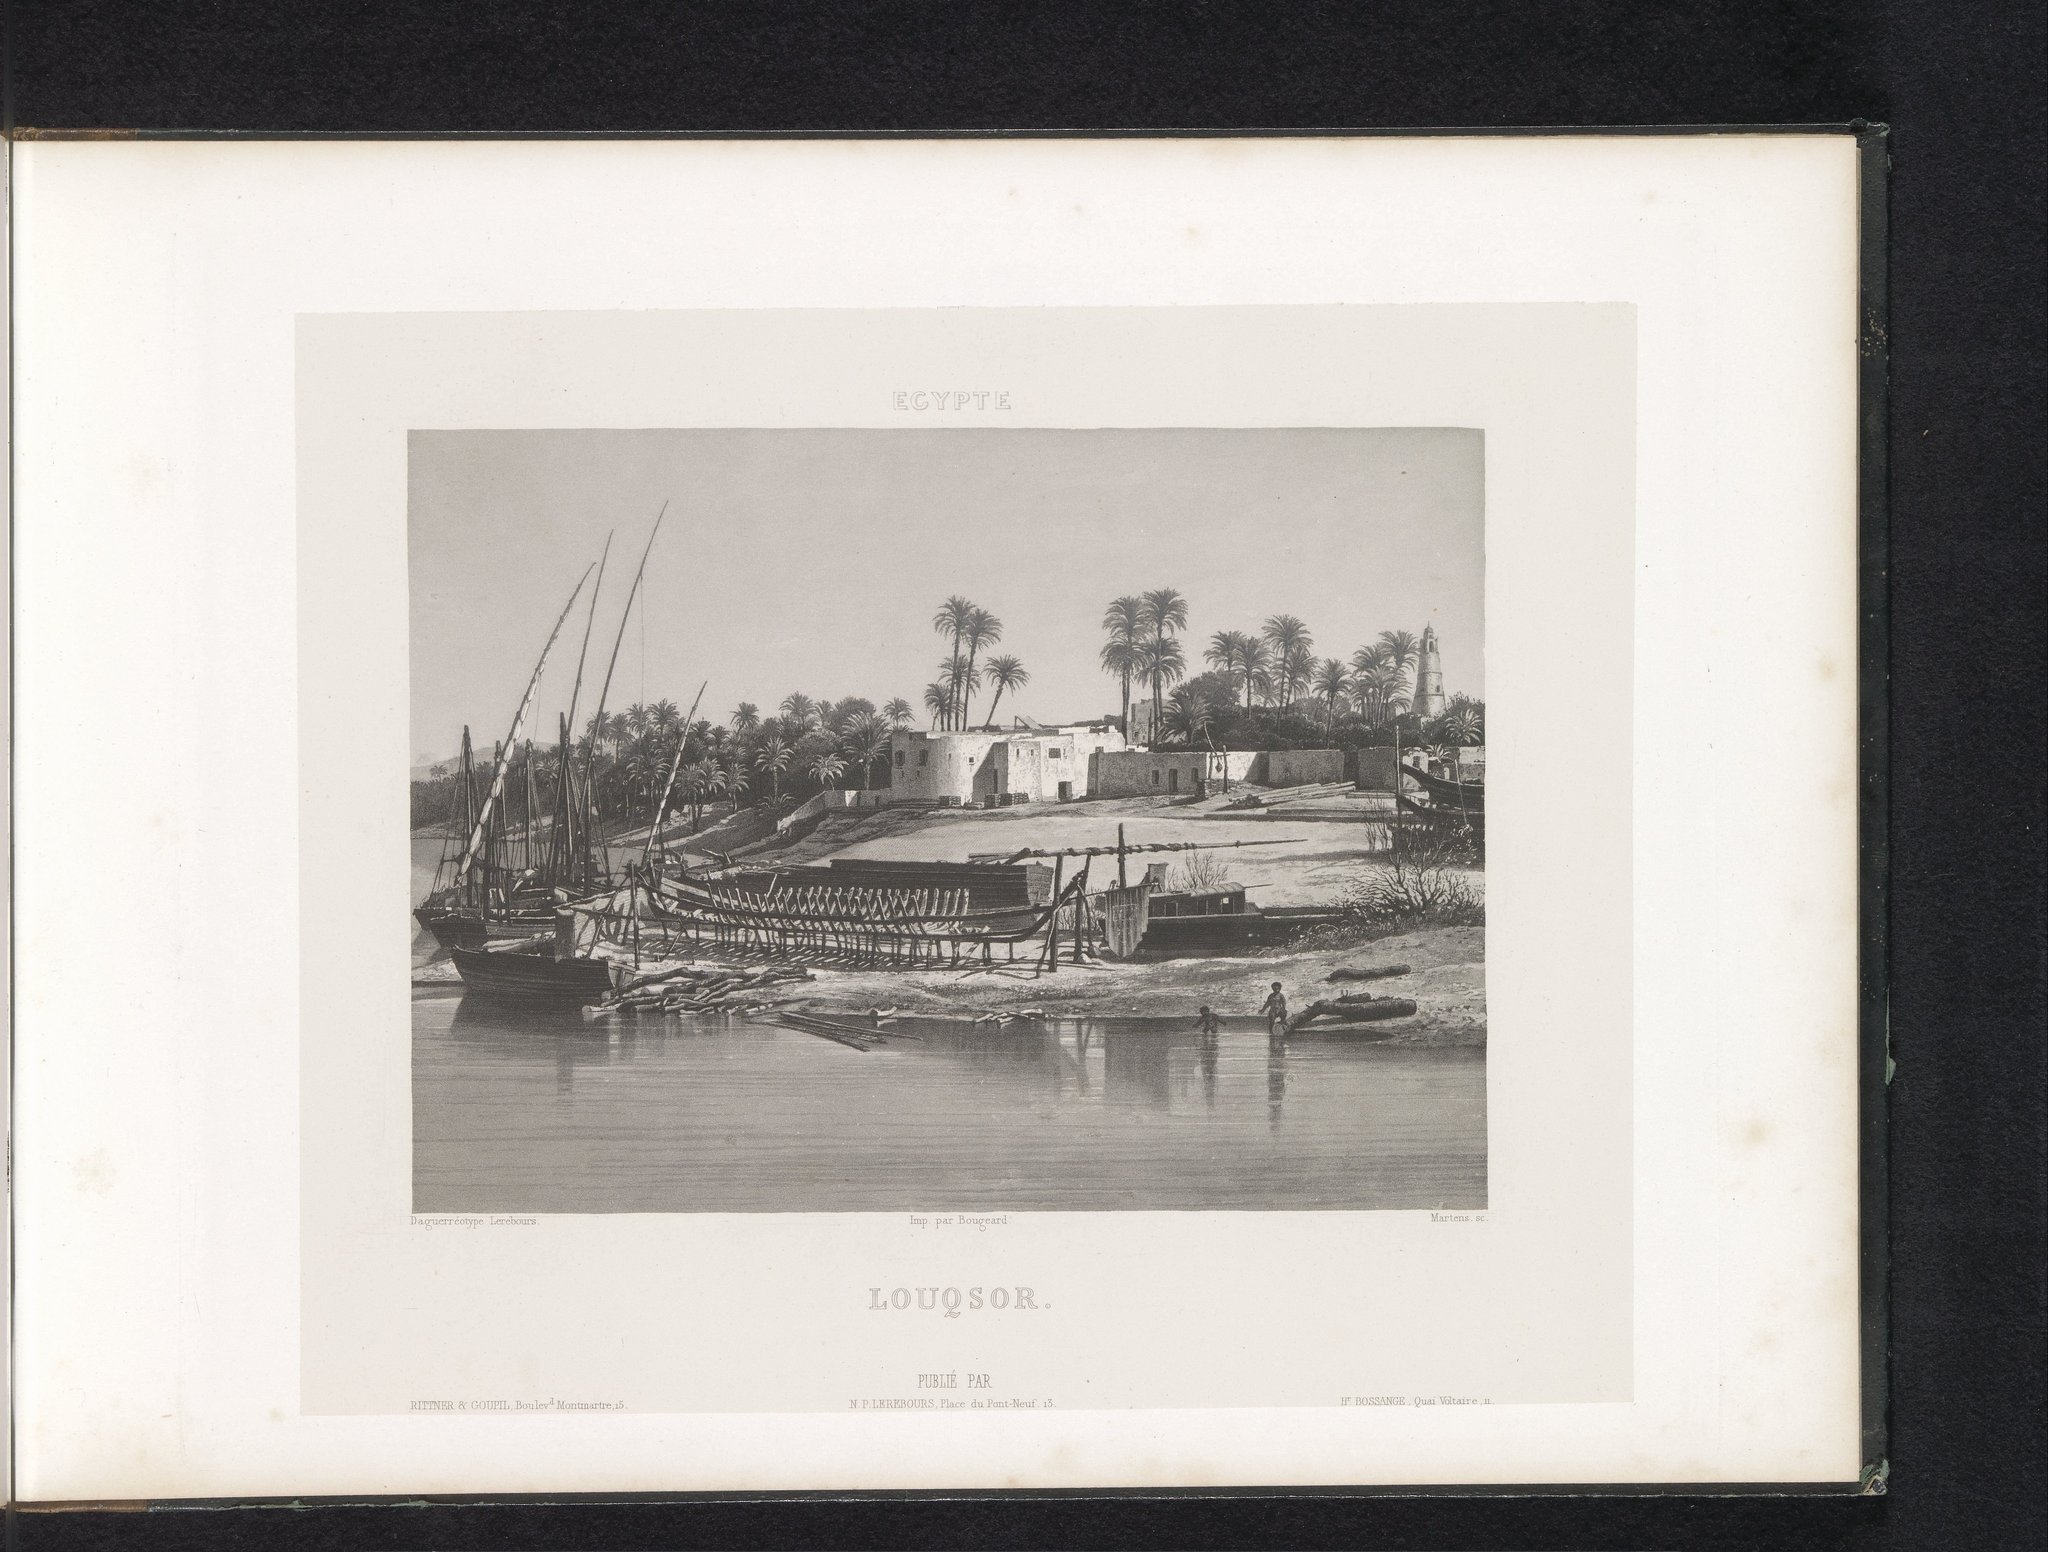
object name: print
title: Louqsor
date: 1839-1841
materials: paper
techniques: aquatint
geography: paris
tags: river, ships, boats on land, beached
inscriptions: inscription: ‘Hr. Bossance Quai Voltaire 11’, inscription: ‘Rittner & Goupil Boulevd Montmartre 15’, inscription: ‘N.P. Lerebours Place du Pont Neuf 15’